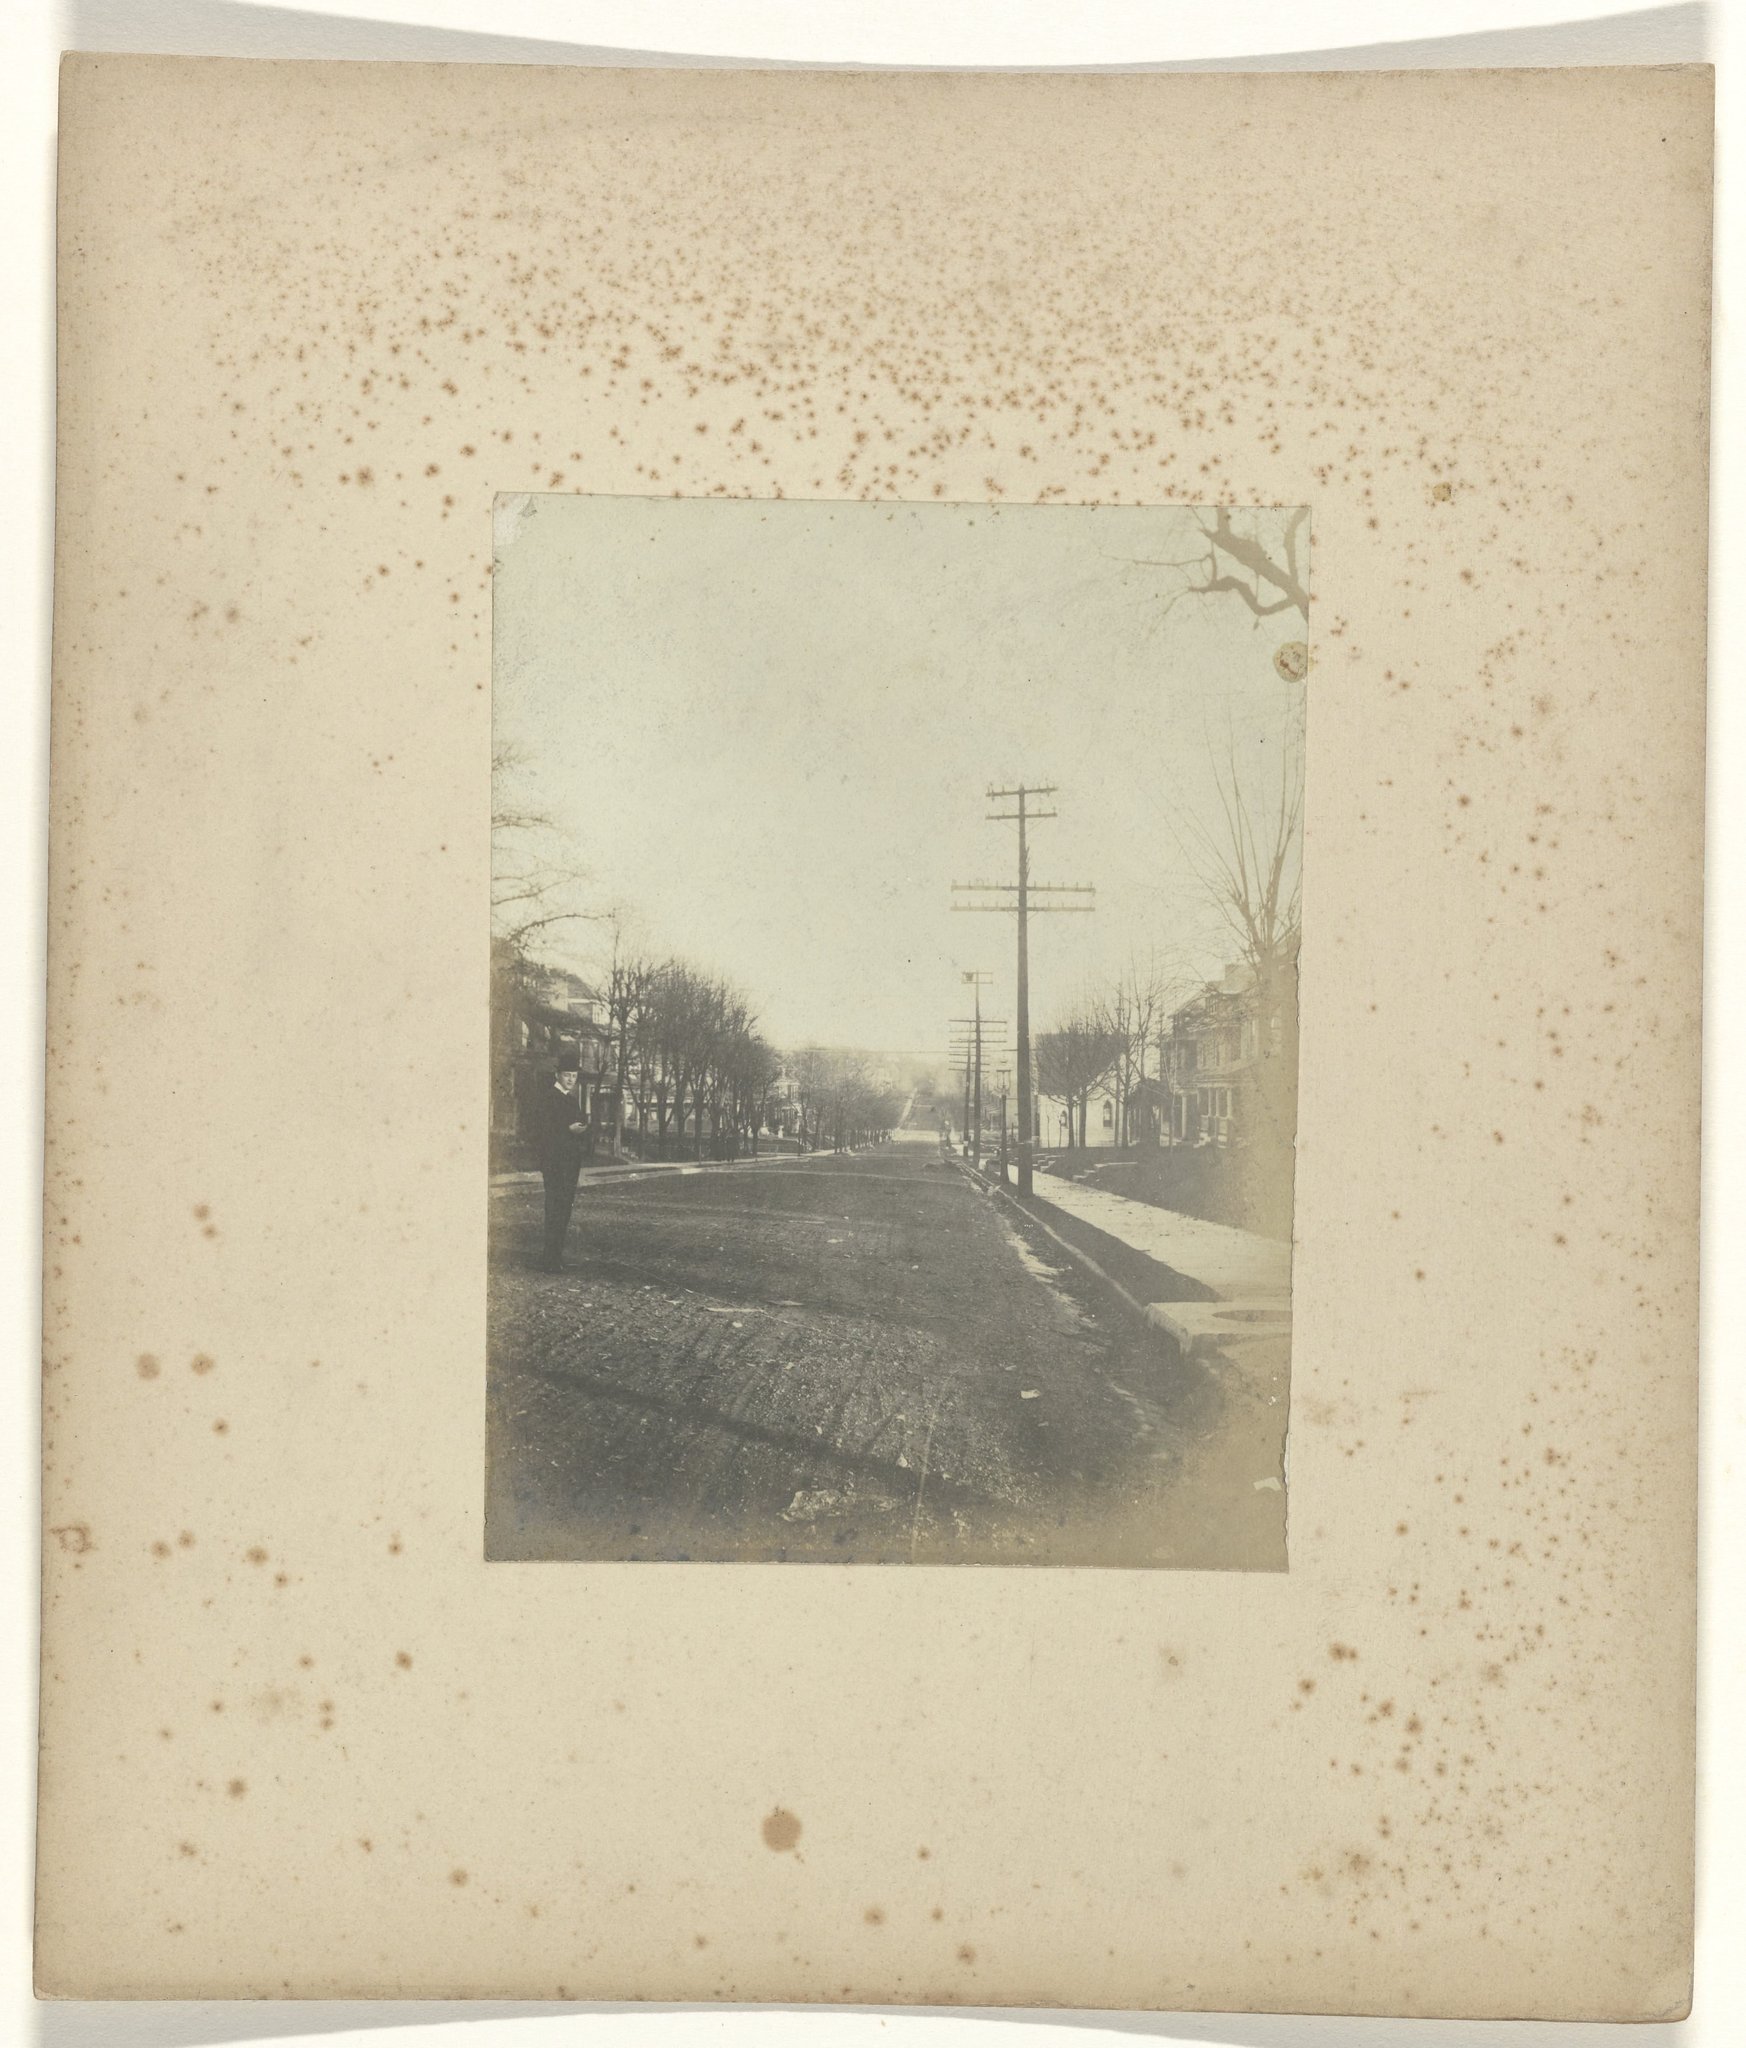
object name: photograph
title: Jan C. Schüller [?] op straat tijdens de wereldtentoonstelling in St. Louis (Louisiana Purchase Exposition), 1904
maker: Anonymous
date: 1905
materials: cardboard, paper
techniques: gelatin silver print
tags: missouri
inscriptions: annotation: ‘1 Jan 1905 // achter Maple arc’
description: Jan C. Schüller [?] op straat tijdens de wereldtentoonstelling in St. Louis (Louisiana Purchase Exposition), 1904.